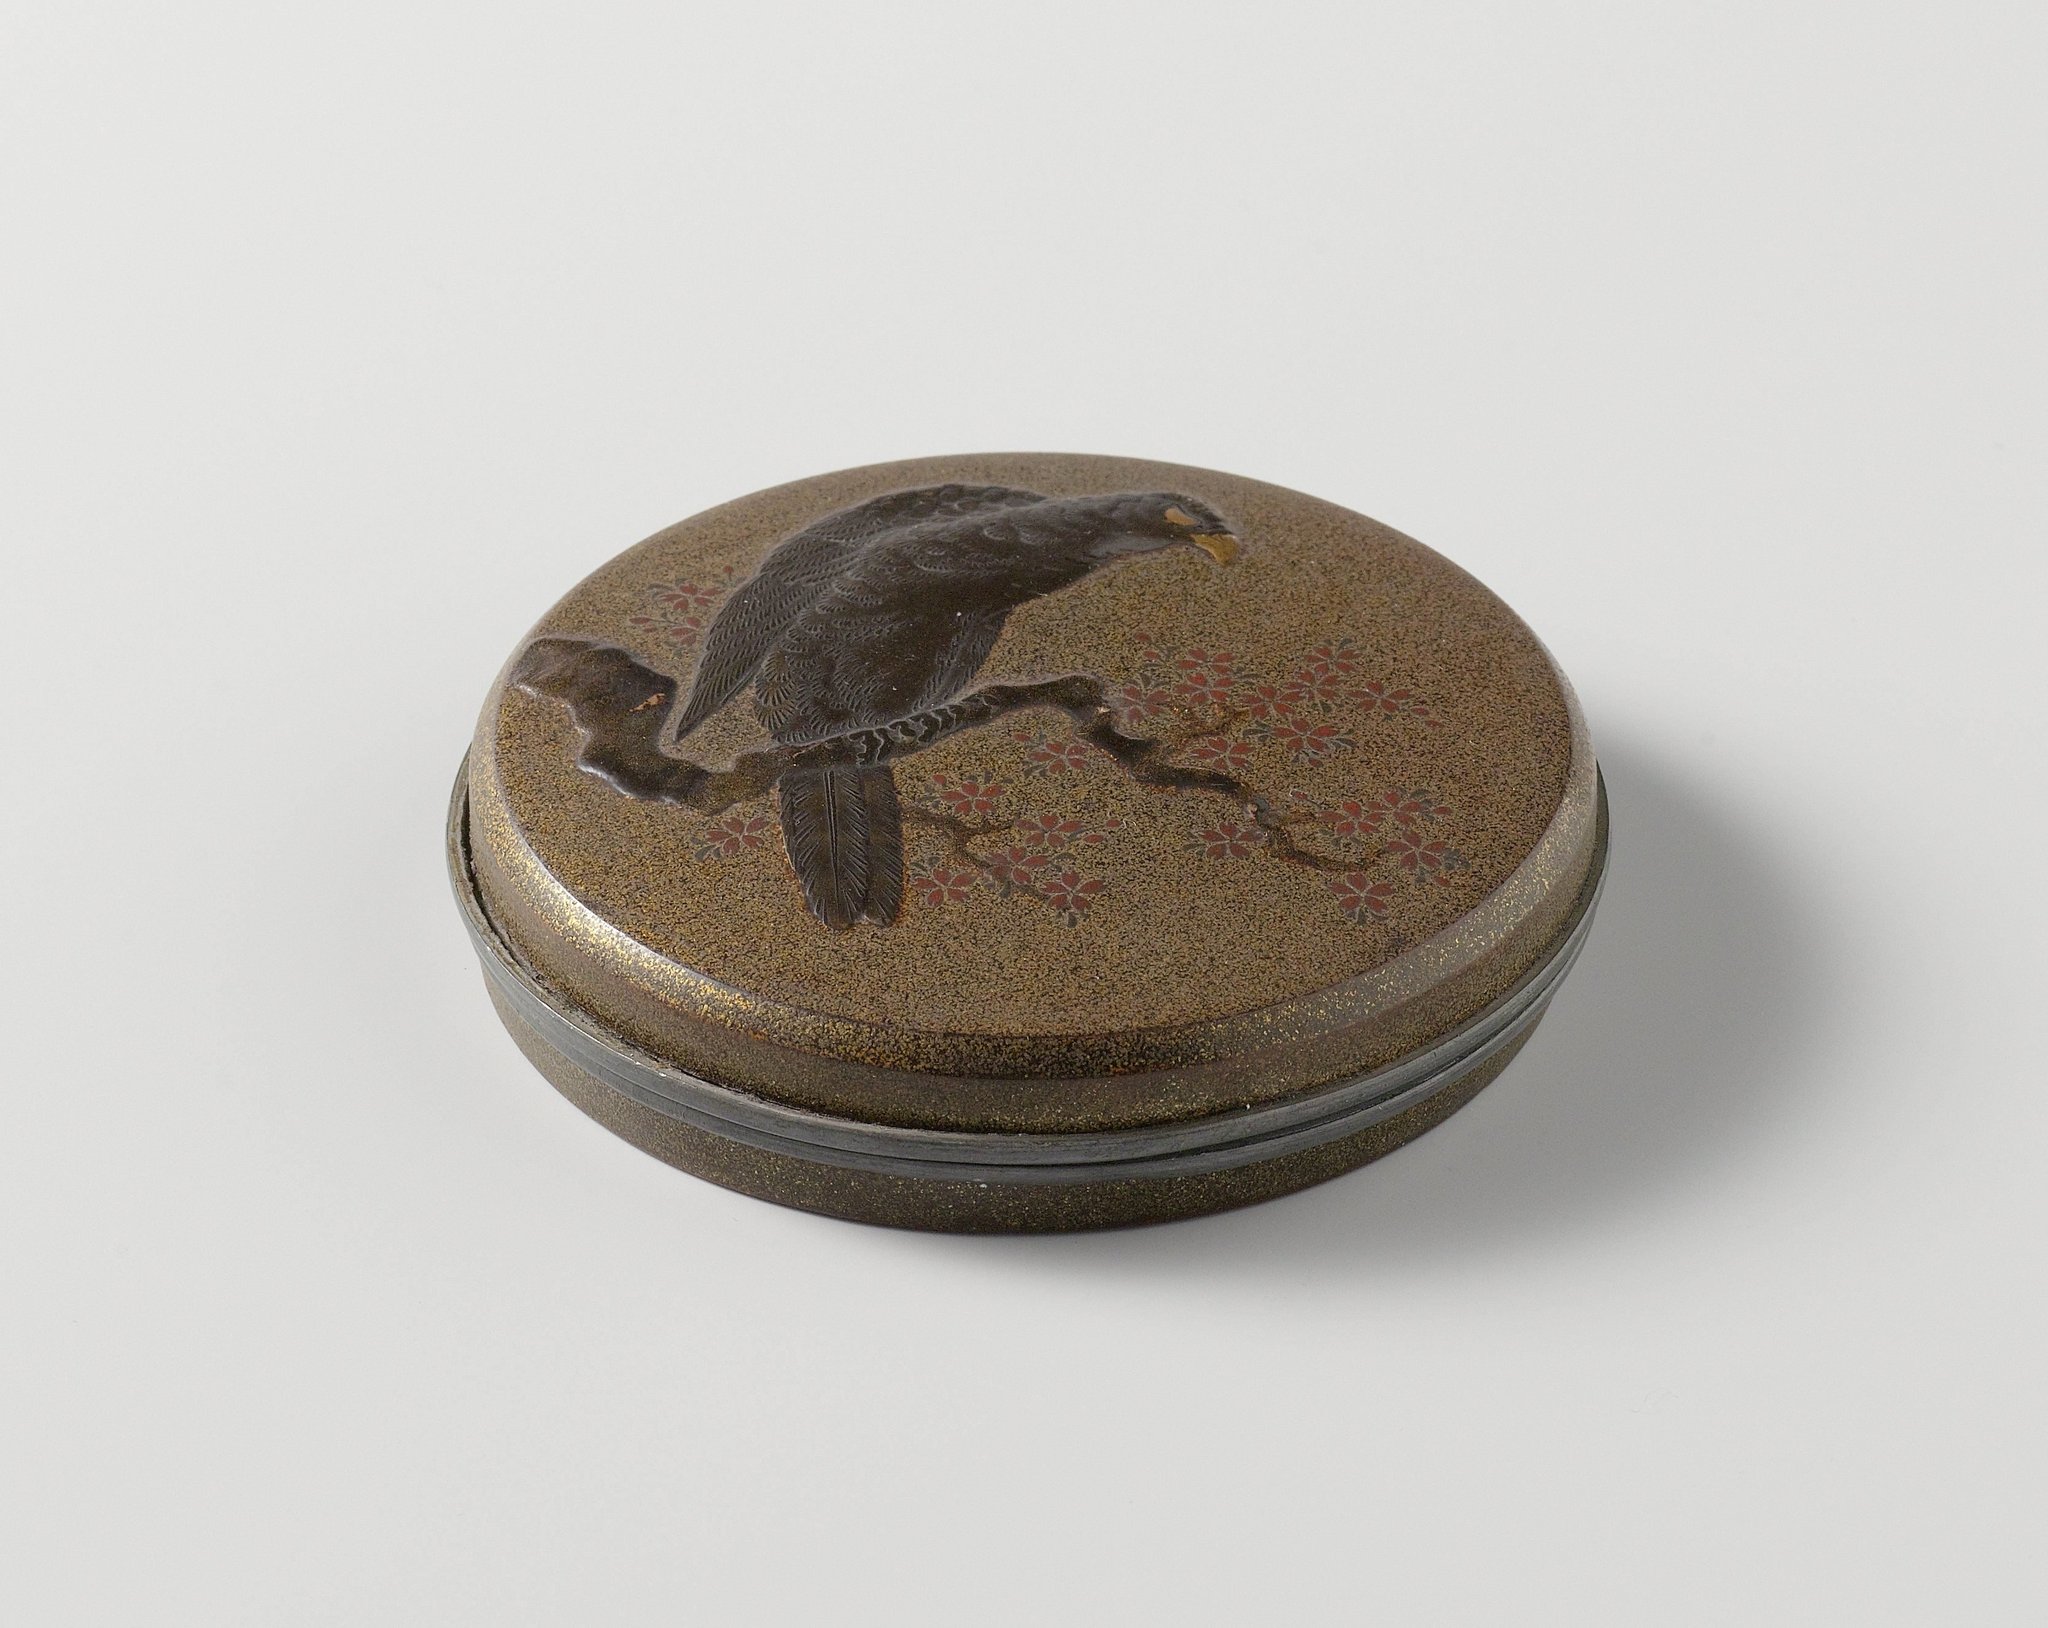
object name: box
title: Ronde doos met goudlak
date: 1775-1800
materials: lacquer, tin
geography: japan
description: Rond doosje met goudlak. Op het deksel een adelaar op een tak. De rand van het doosje en van het deksel is met tin gemonteerd.